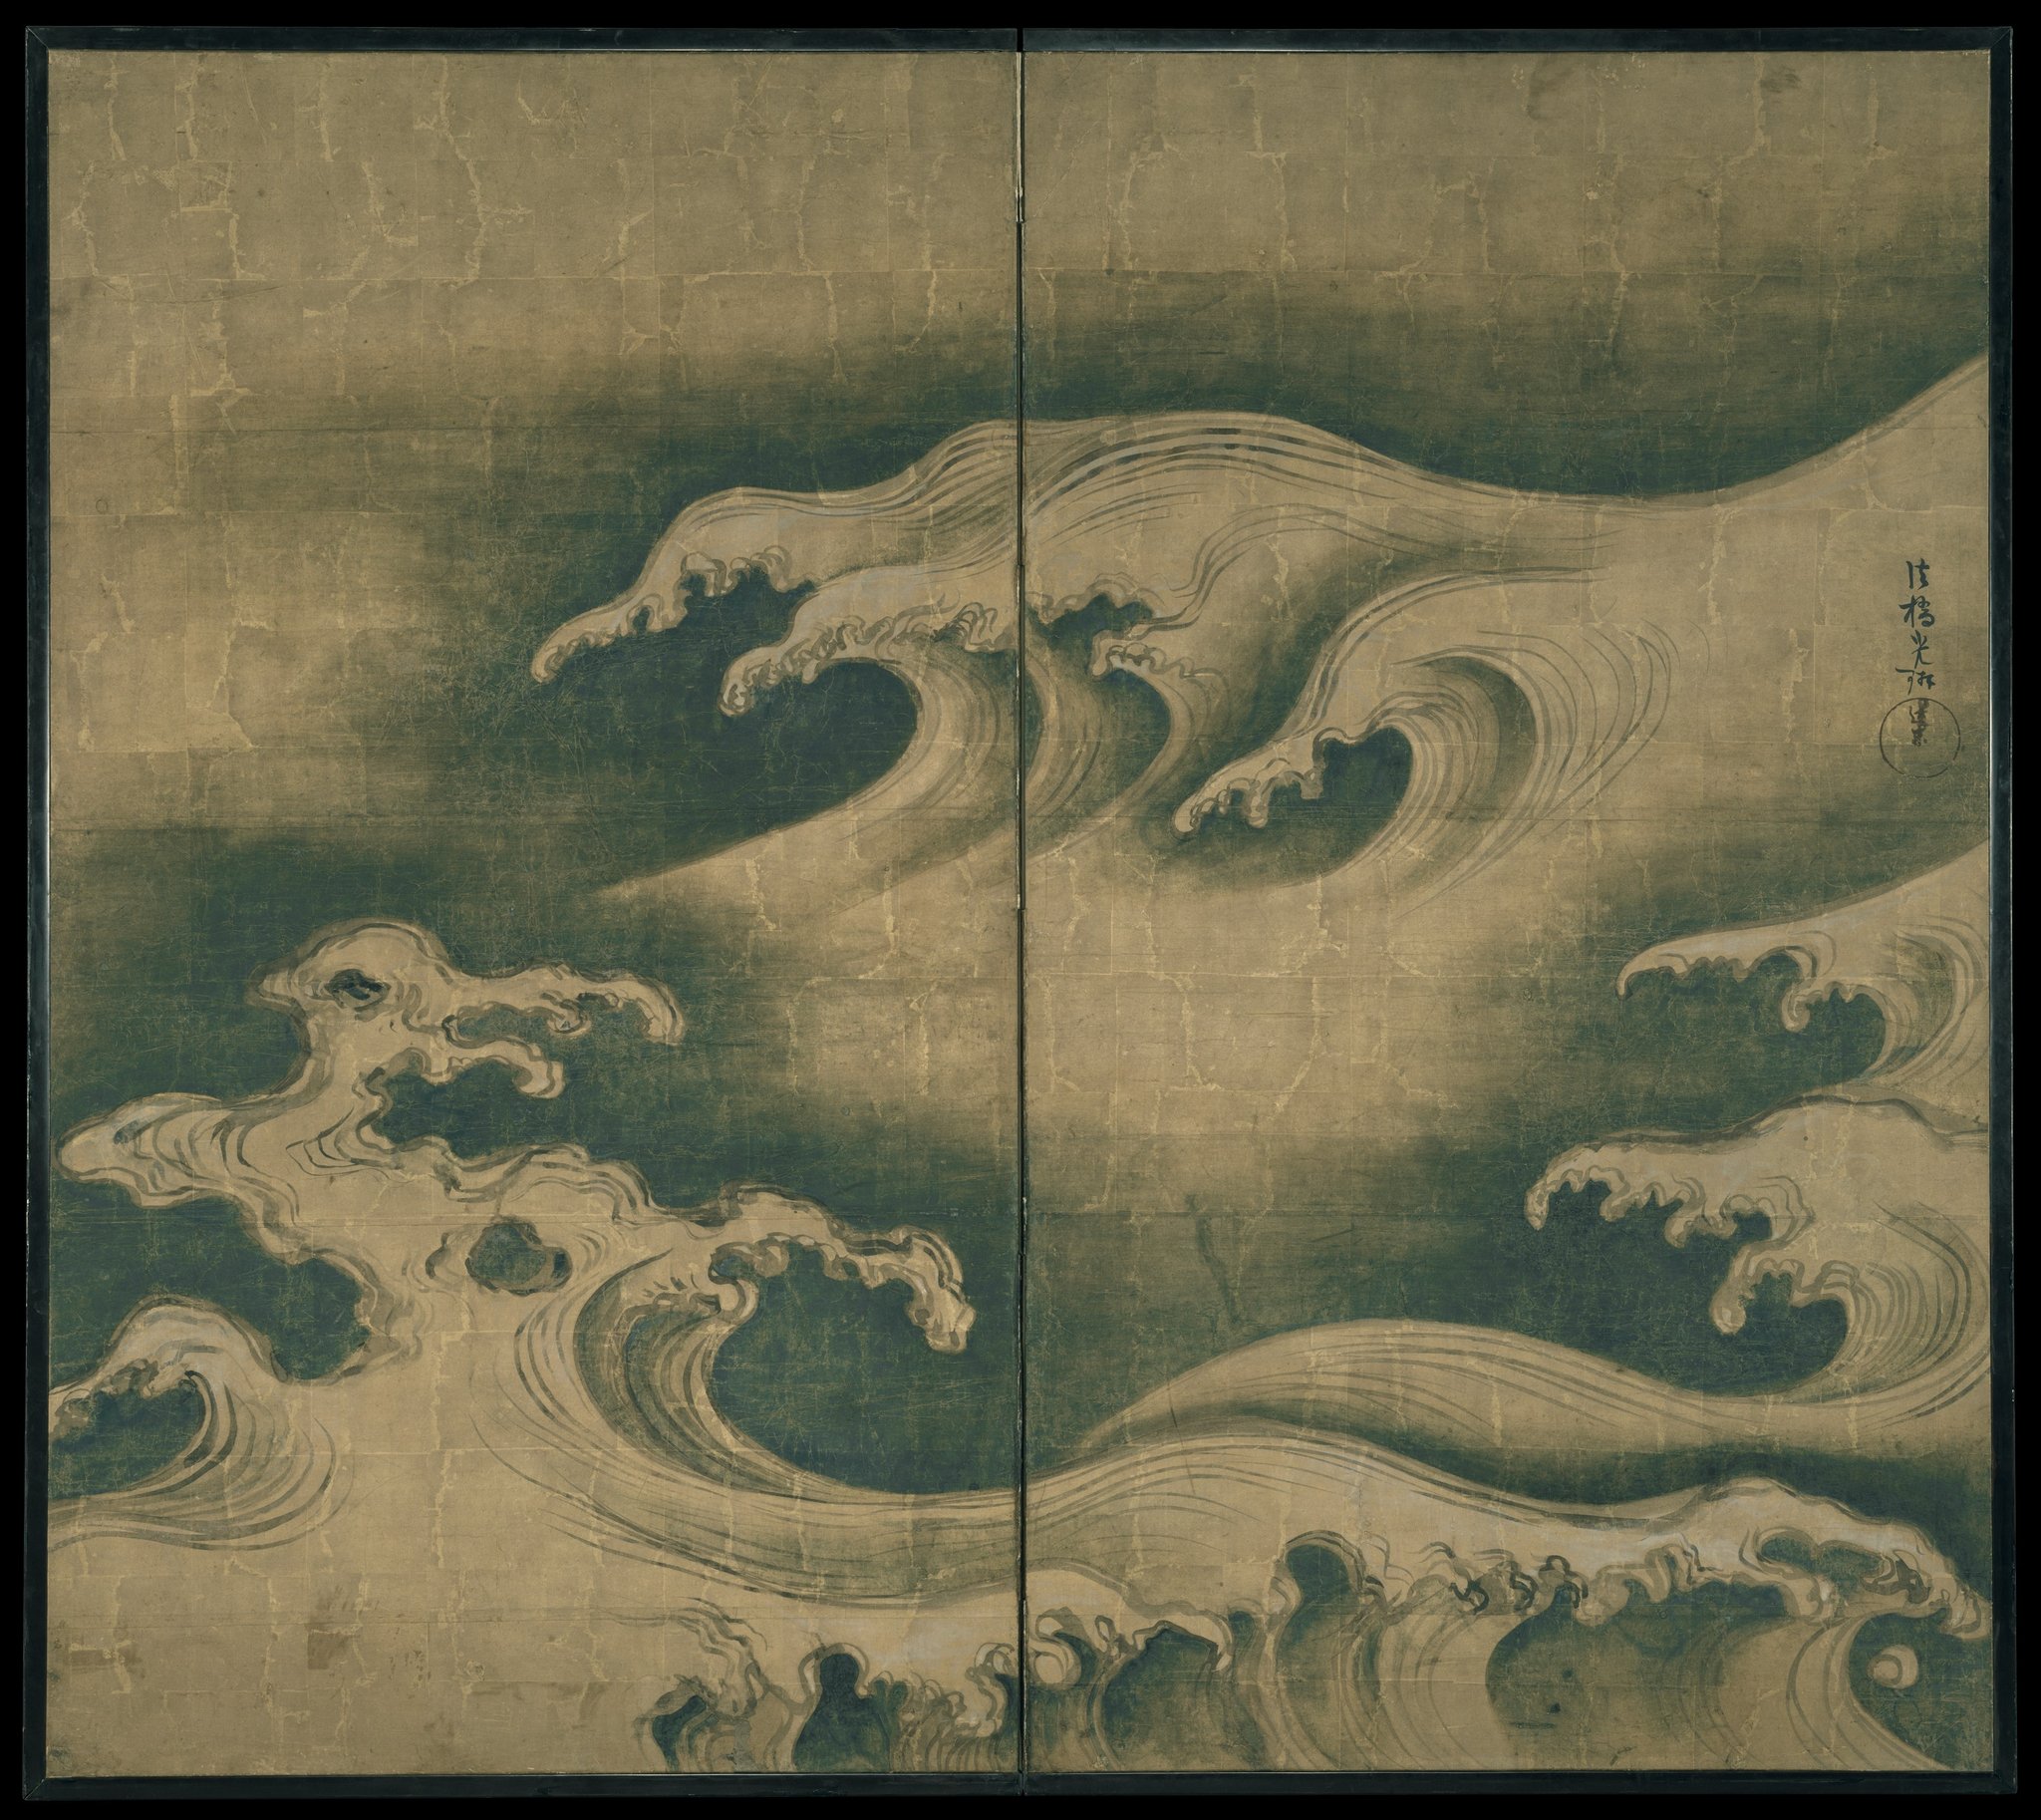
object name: screen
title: Rough Waves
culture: japanese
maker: ogata kōrin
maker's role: artist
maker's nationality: japanese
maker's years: 1658-1716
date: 1704-1709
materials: gold leaf, ink, panel, paper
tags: waves